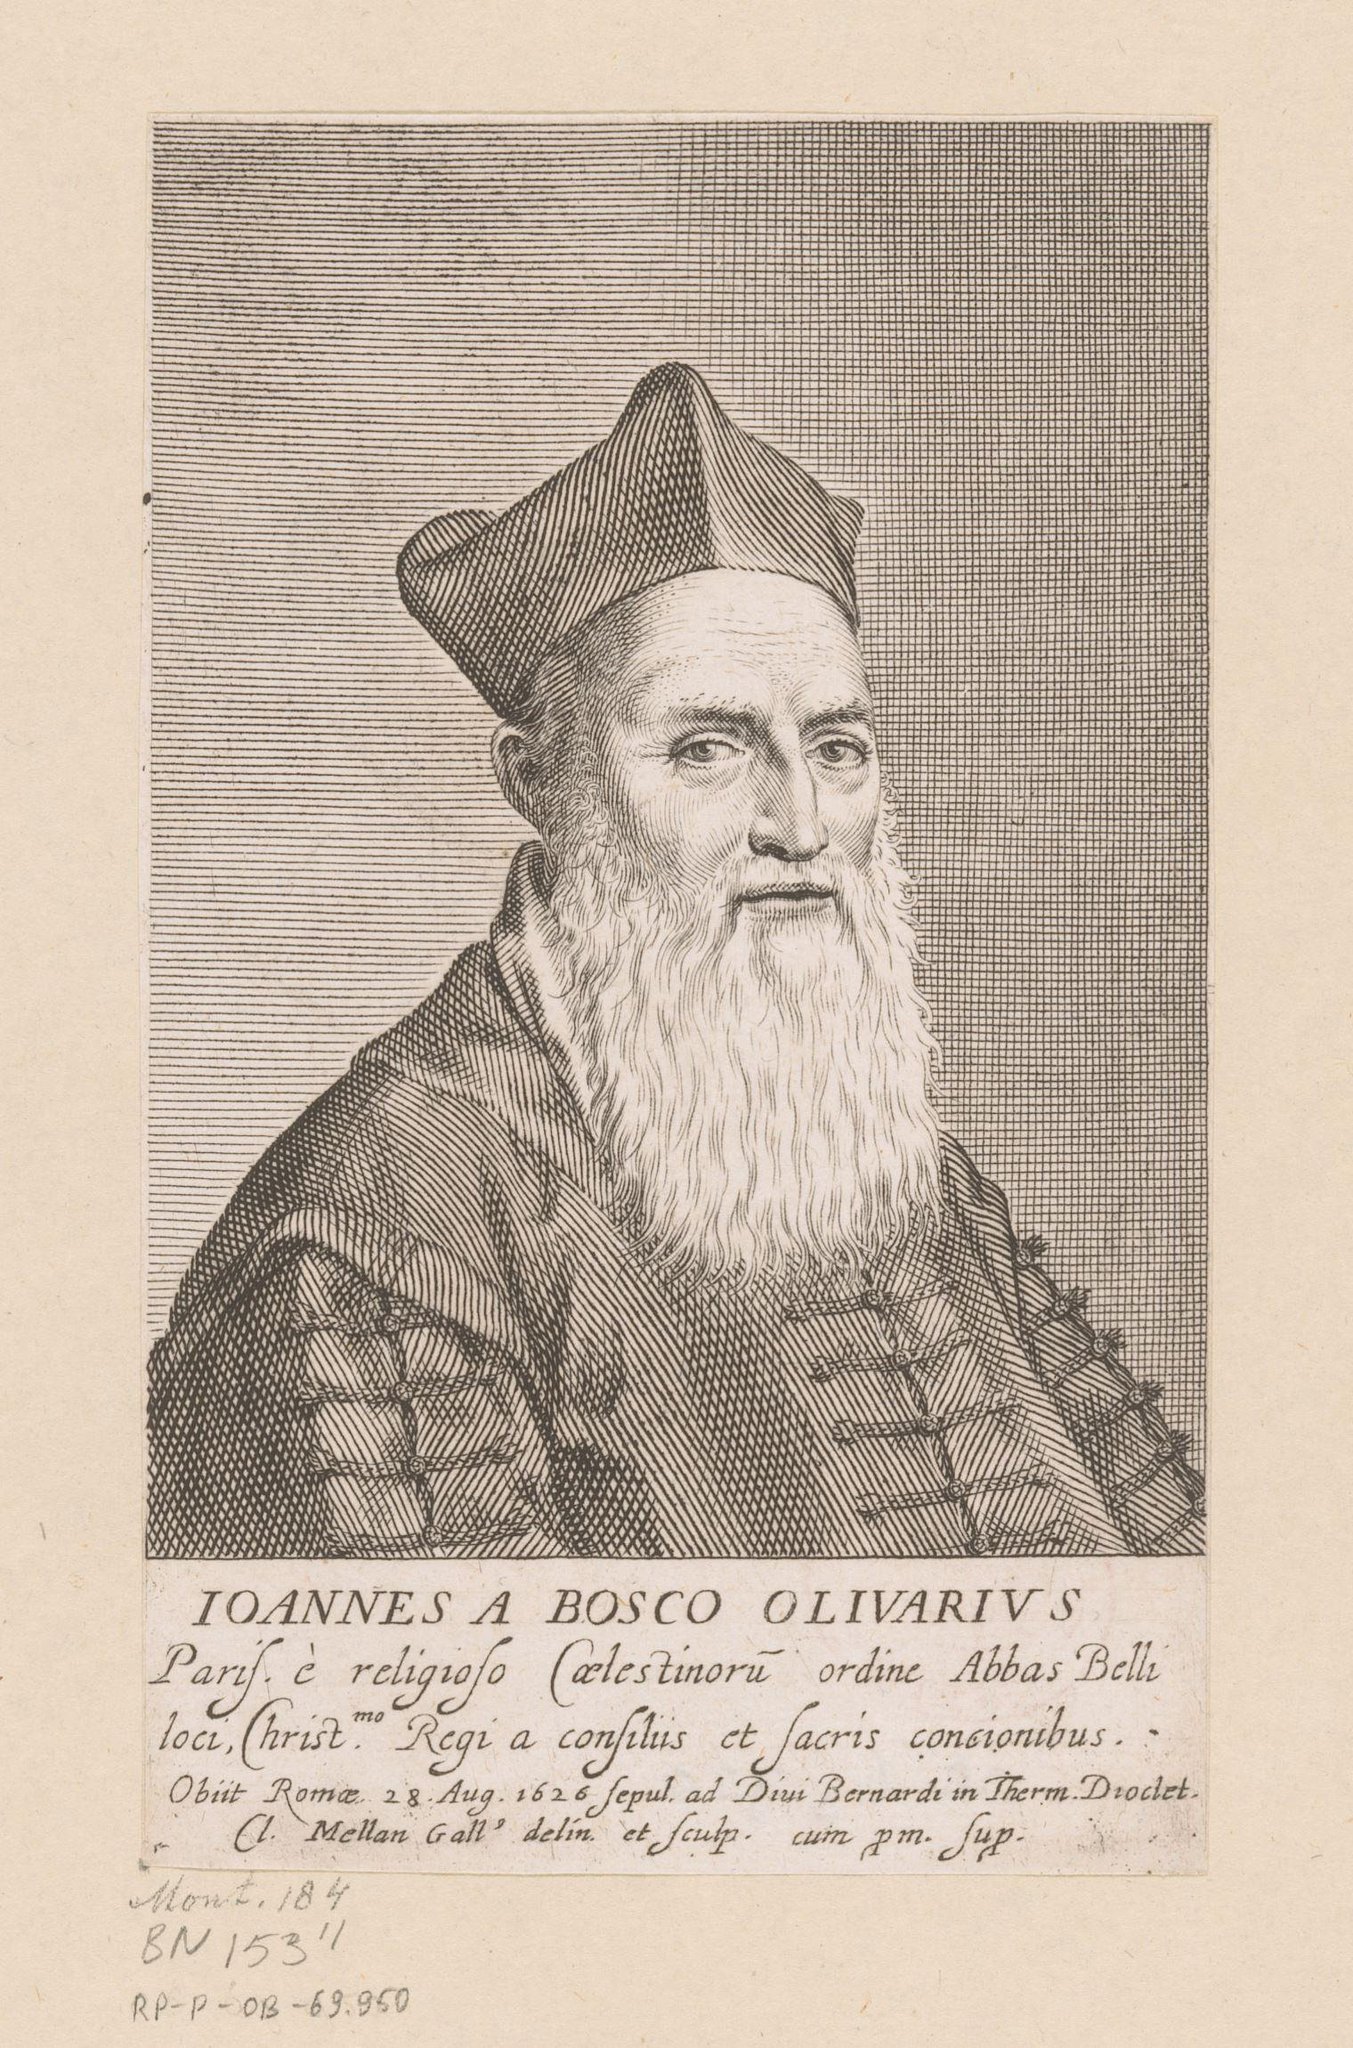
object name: print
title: Portret van Jean du Bois-Olivier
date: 1626-1688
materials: paper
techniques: engraving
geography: italy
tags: rome, clergyman, historical persons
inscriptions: collector's mark: Lugt 240